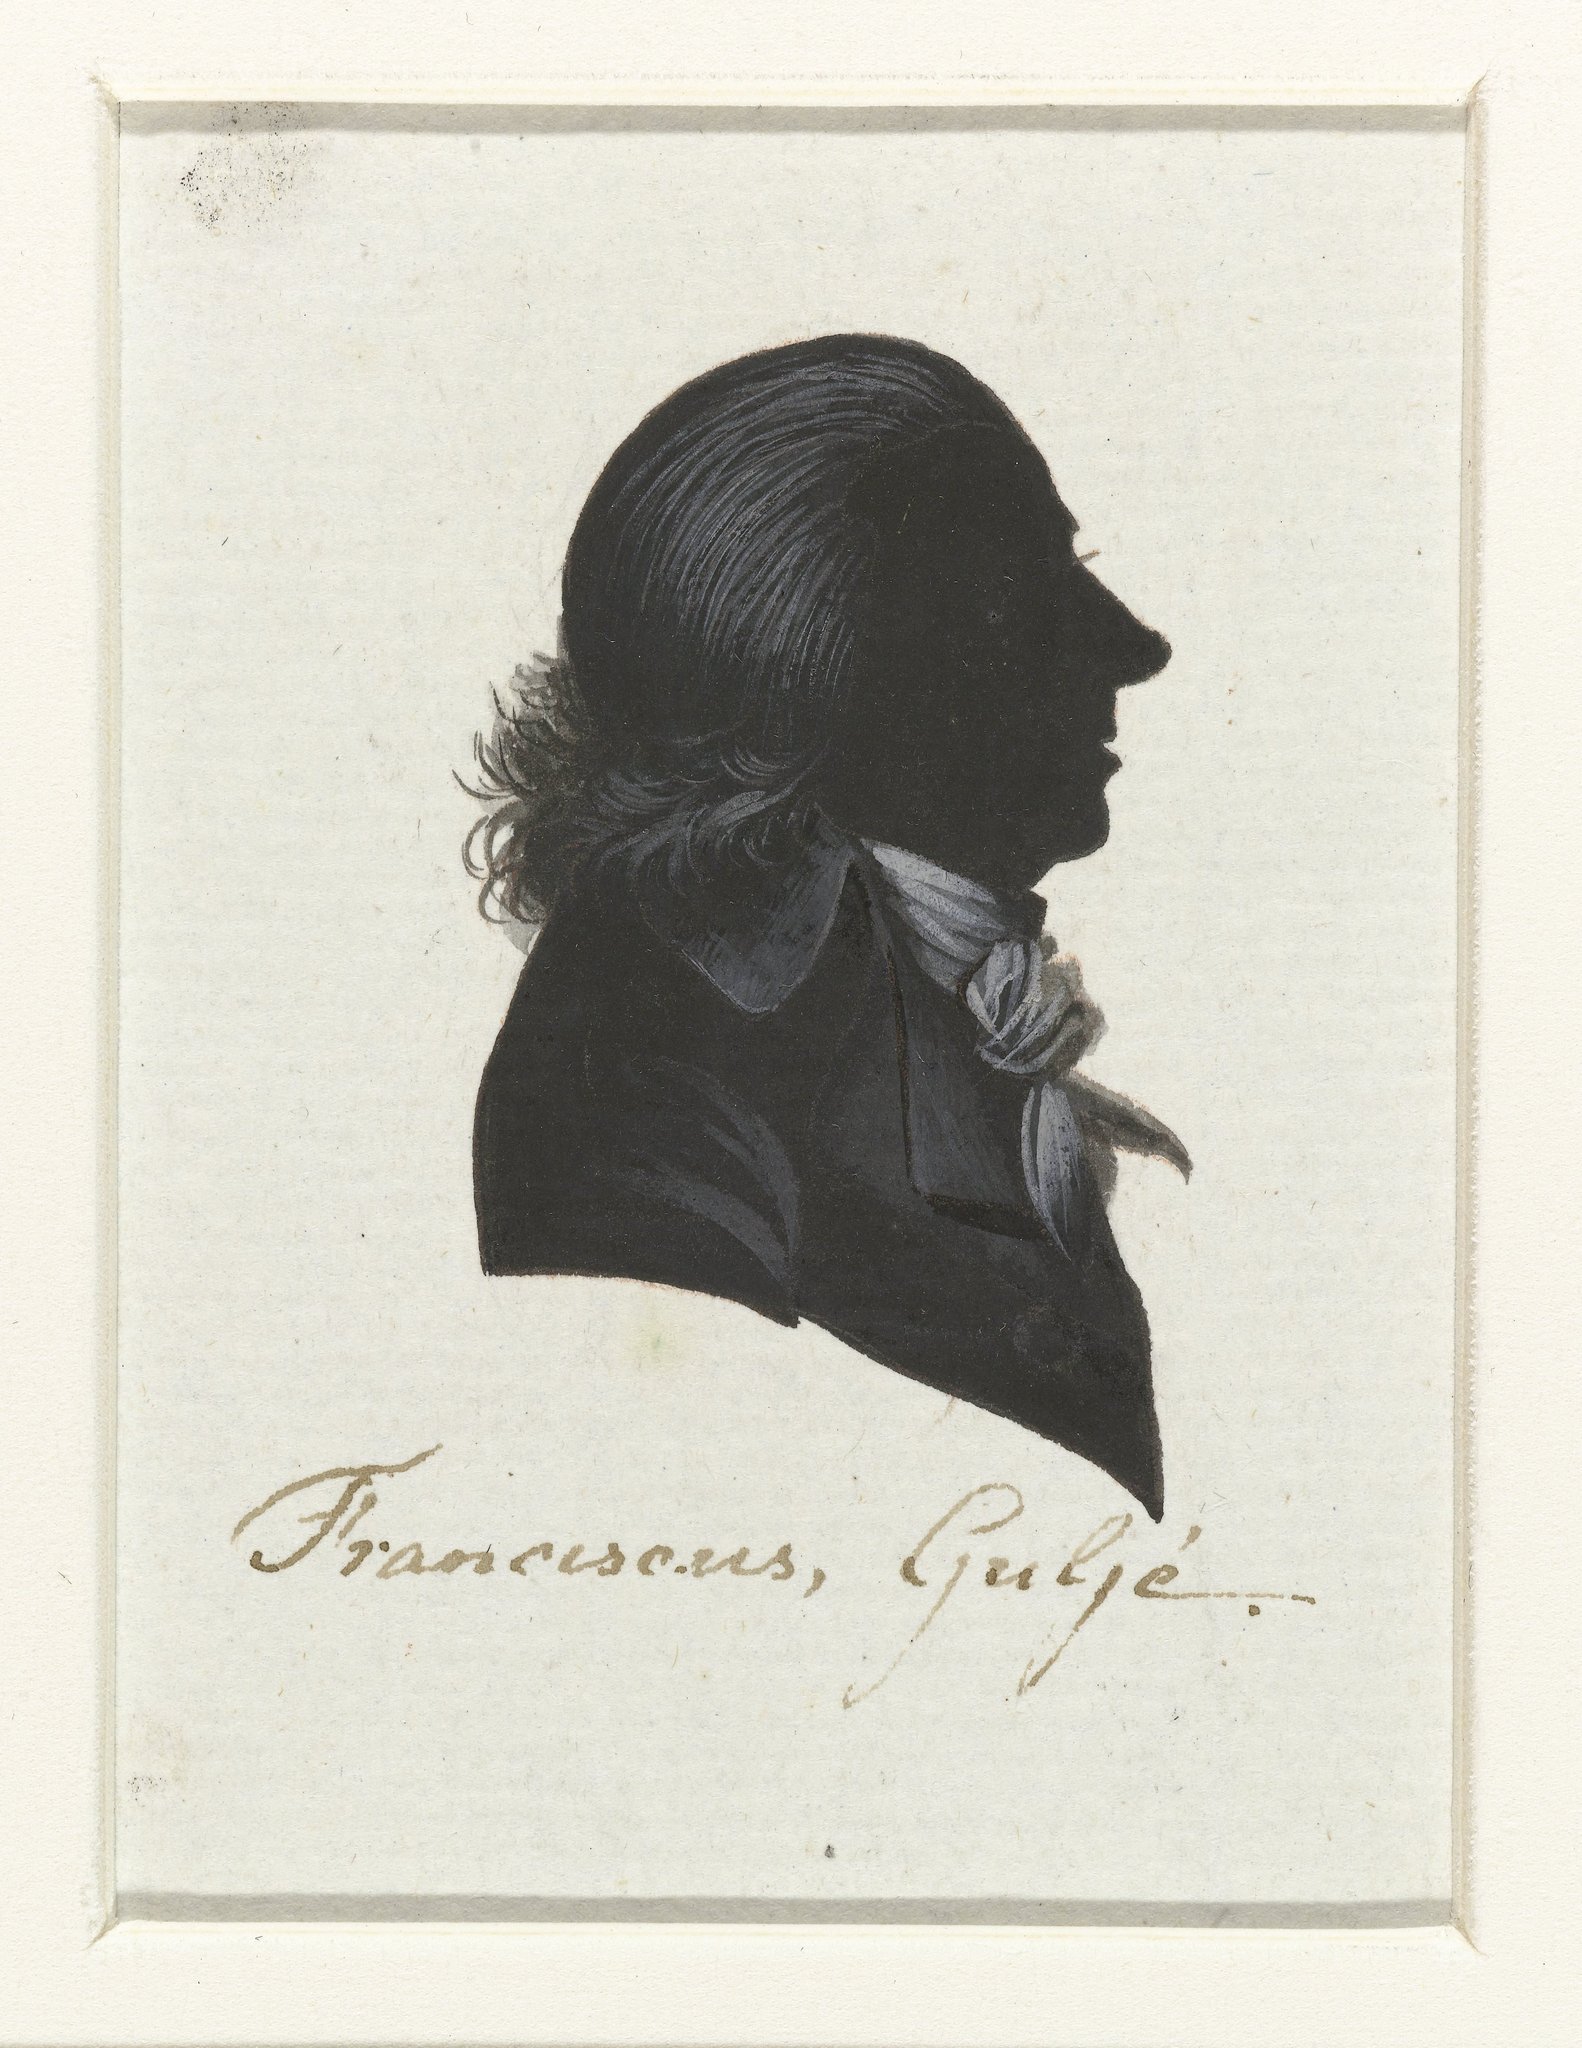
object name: silhouette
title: Representanten van de eerste Nationale Vergadering van de Bataafse Republiek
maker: hausdorff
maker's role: draughtsman, print maker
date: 1796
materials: ink, paper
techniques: drawing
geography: netherlands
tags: historical persons (+ profile portrait), the hague, veghel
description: Silhouettes of members of the National Assembly. India ink on paper, 1796. Early in 1795 Stadholder William V fled to England. In the Republic a new regime was installed. A year later, the country held its first general election. Every Dutch man over the age of twenty and not on poor relief was entitled to vote for a candidate to the National Assembly, the parliament of the Batavian Republic, as the country was known between 1795 and 1806. The 126 representatives who sat in the assembly were drawn from the educated, progressive elite of Dutch society.